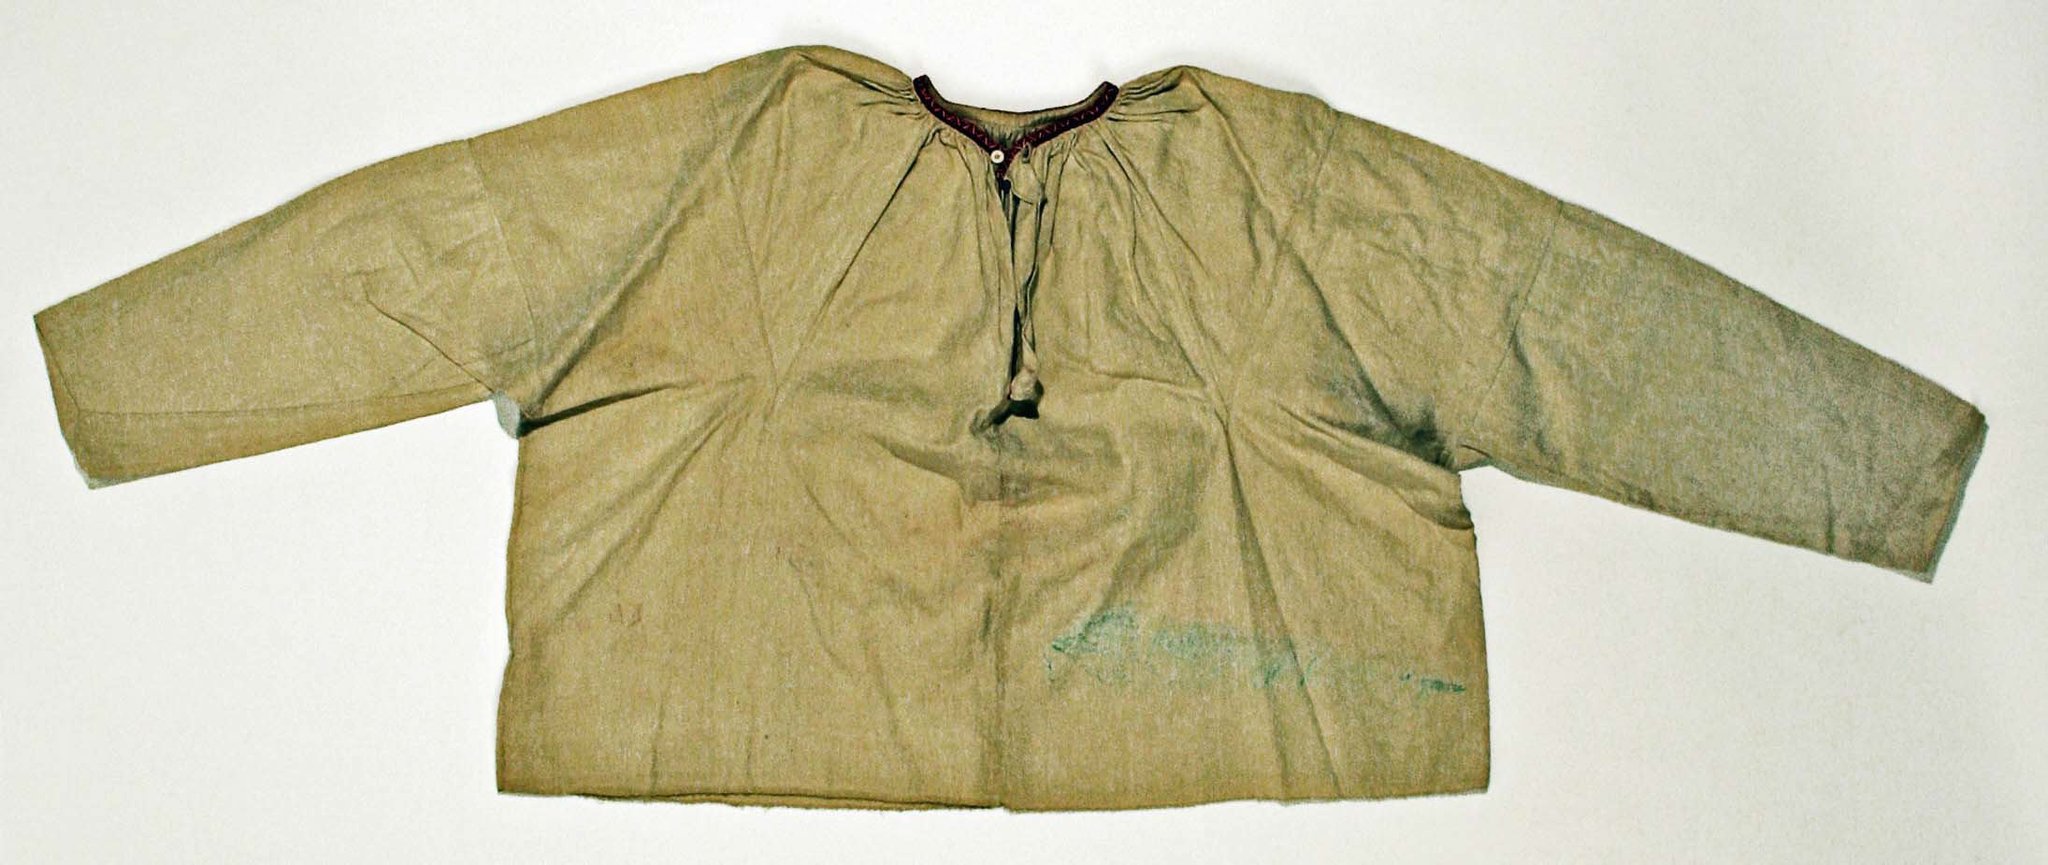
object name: blouse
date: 1801-1900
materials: linen